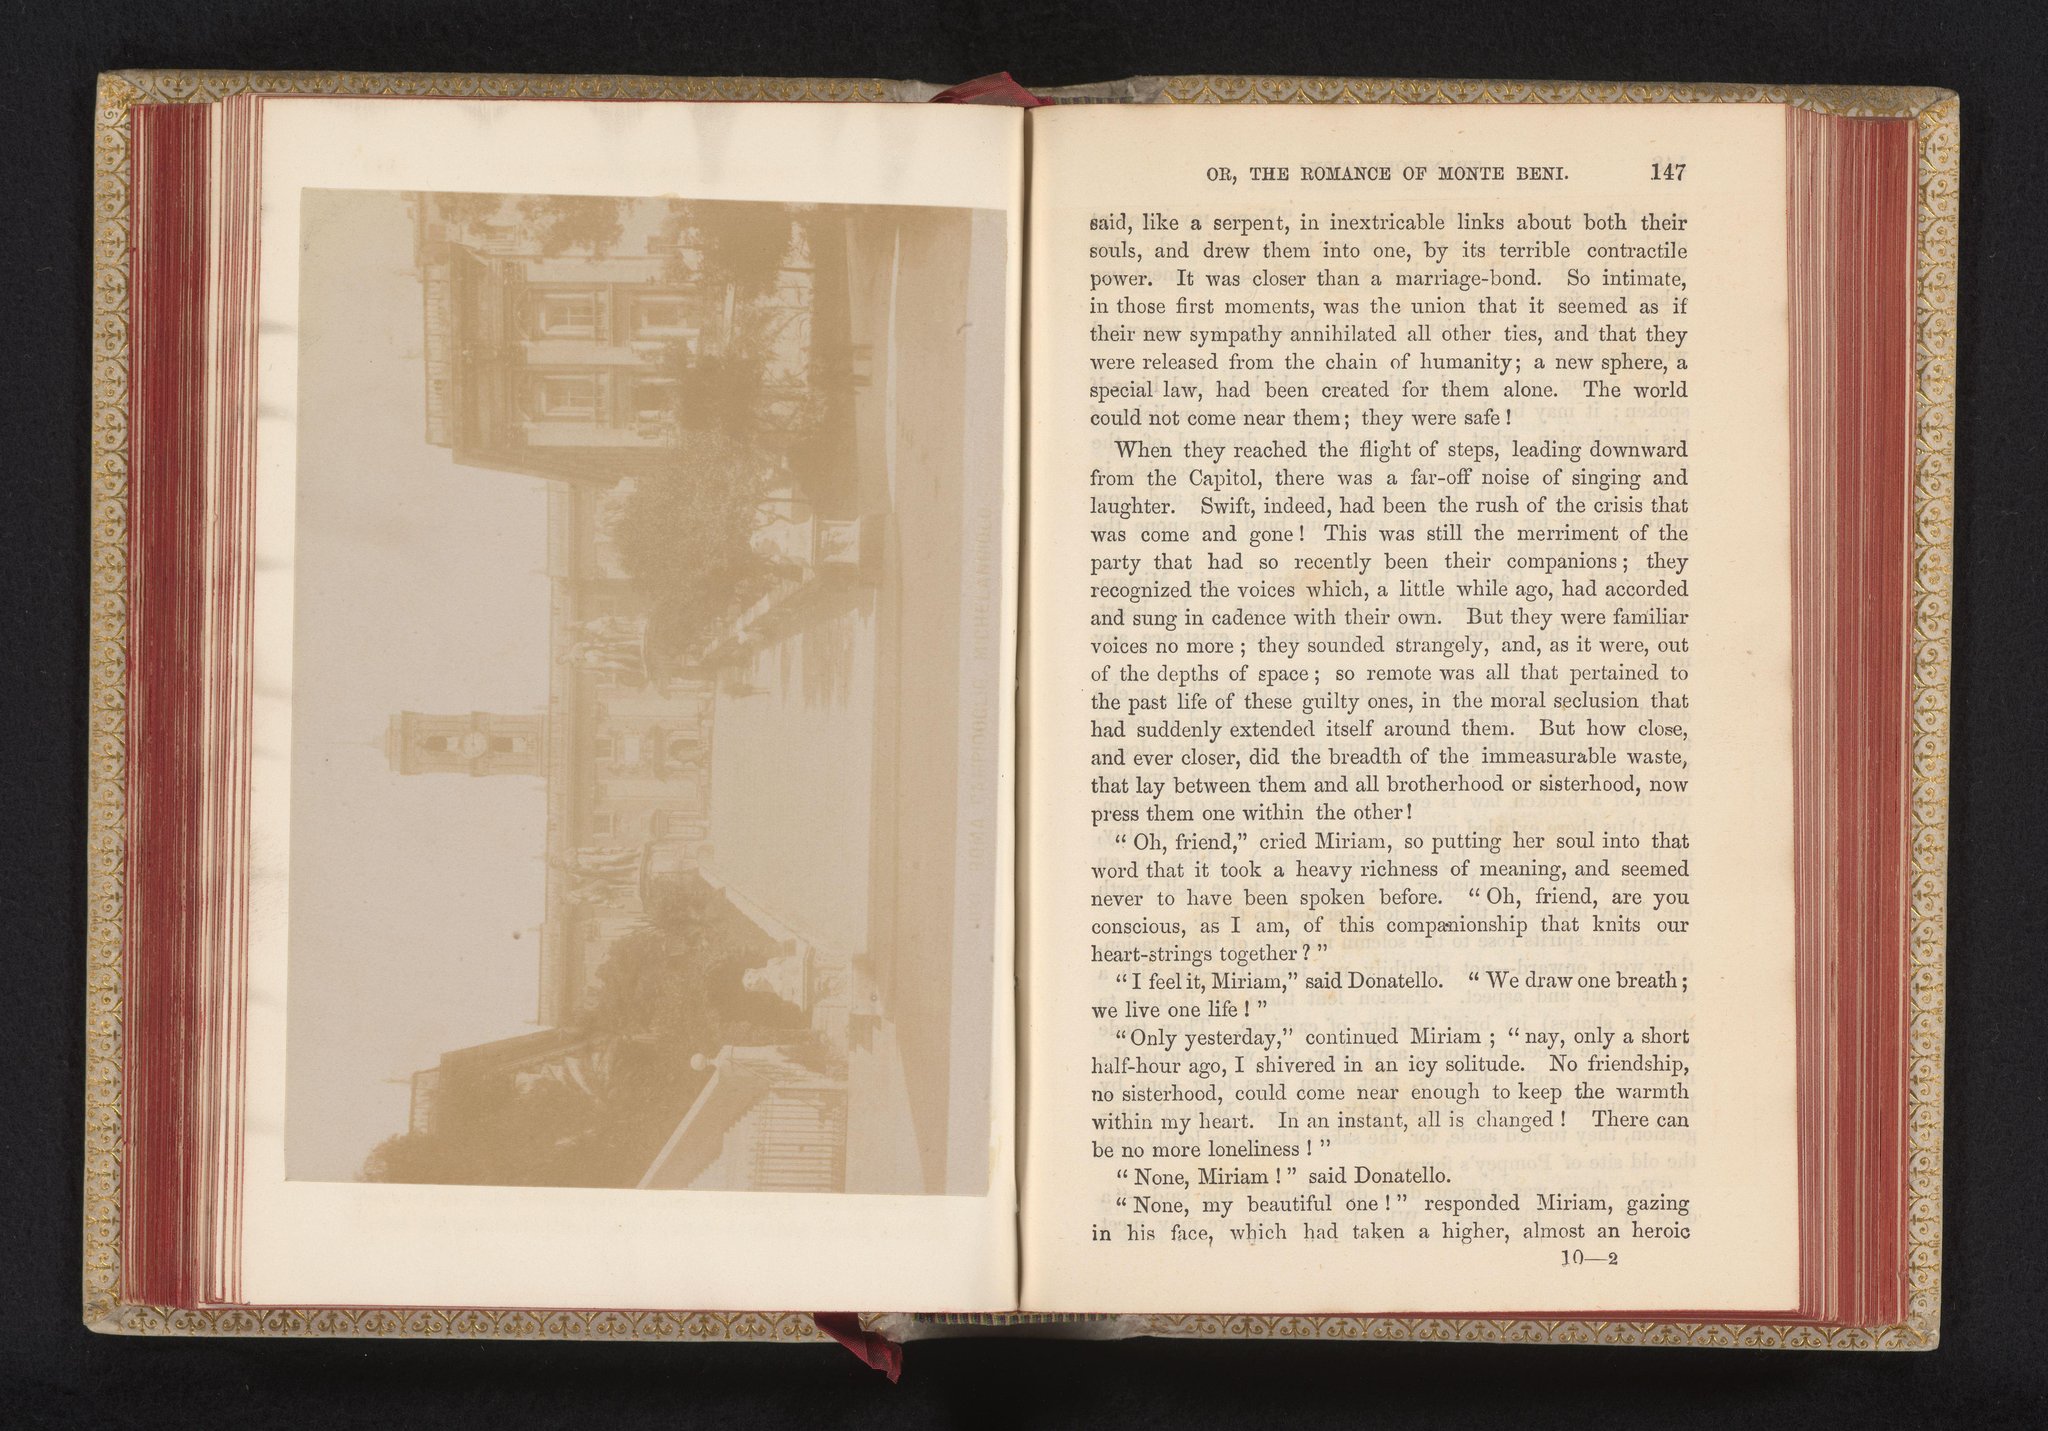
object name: page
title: Roma, Campidoglio Michelangiolo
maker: Anonymous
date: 1883-1888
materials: paper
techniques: albumen print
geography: rome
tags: square, place, circus, etc., palace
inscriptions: number: ‘[onleesbaar]’